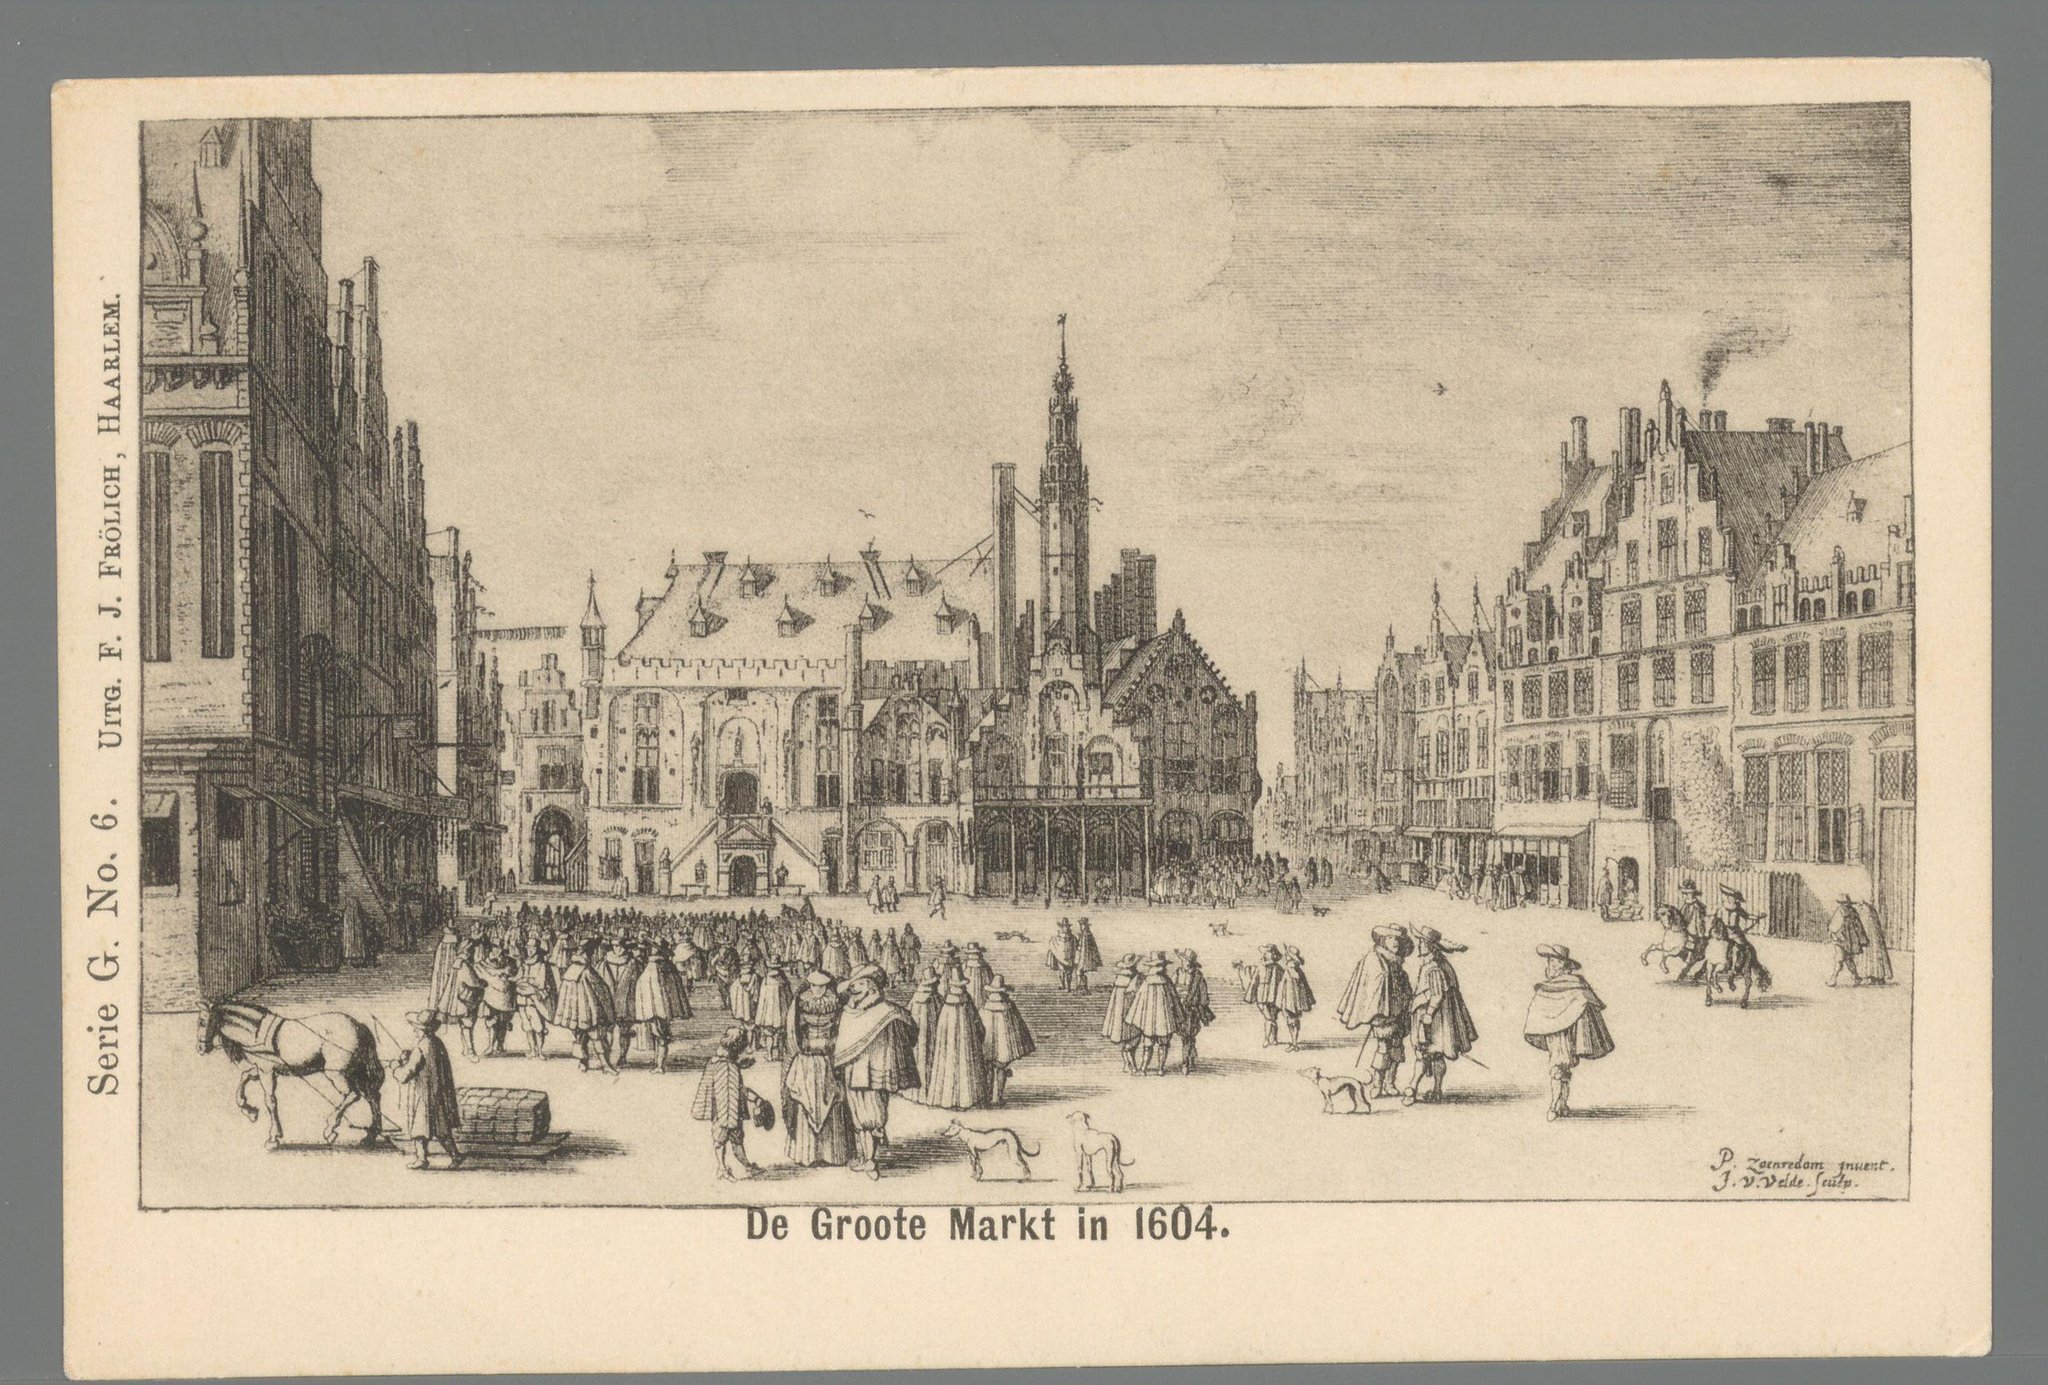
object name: reproduction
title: De Groote Markt in 1604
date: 1892-1905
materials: cardboard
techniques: photograph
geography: haarlem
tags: square, place, circus, etc., city-view, and landscape with man-made constructions, townhall, market, haarlem